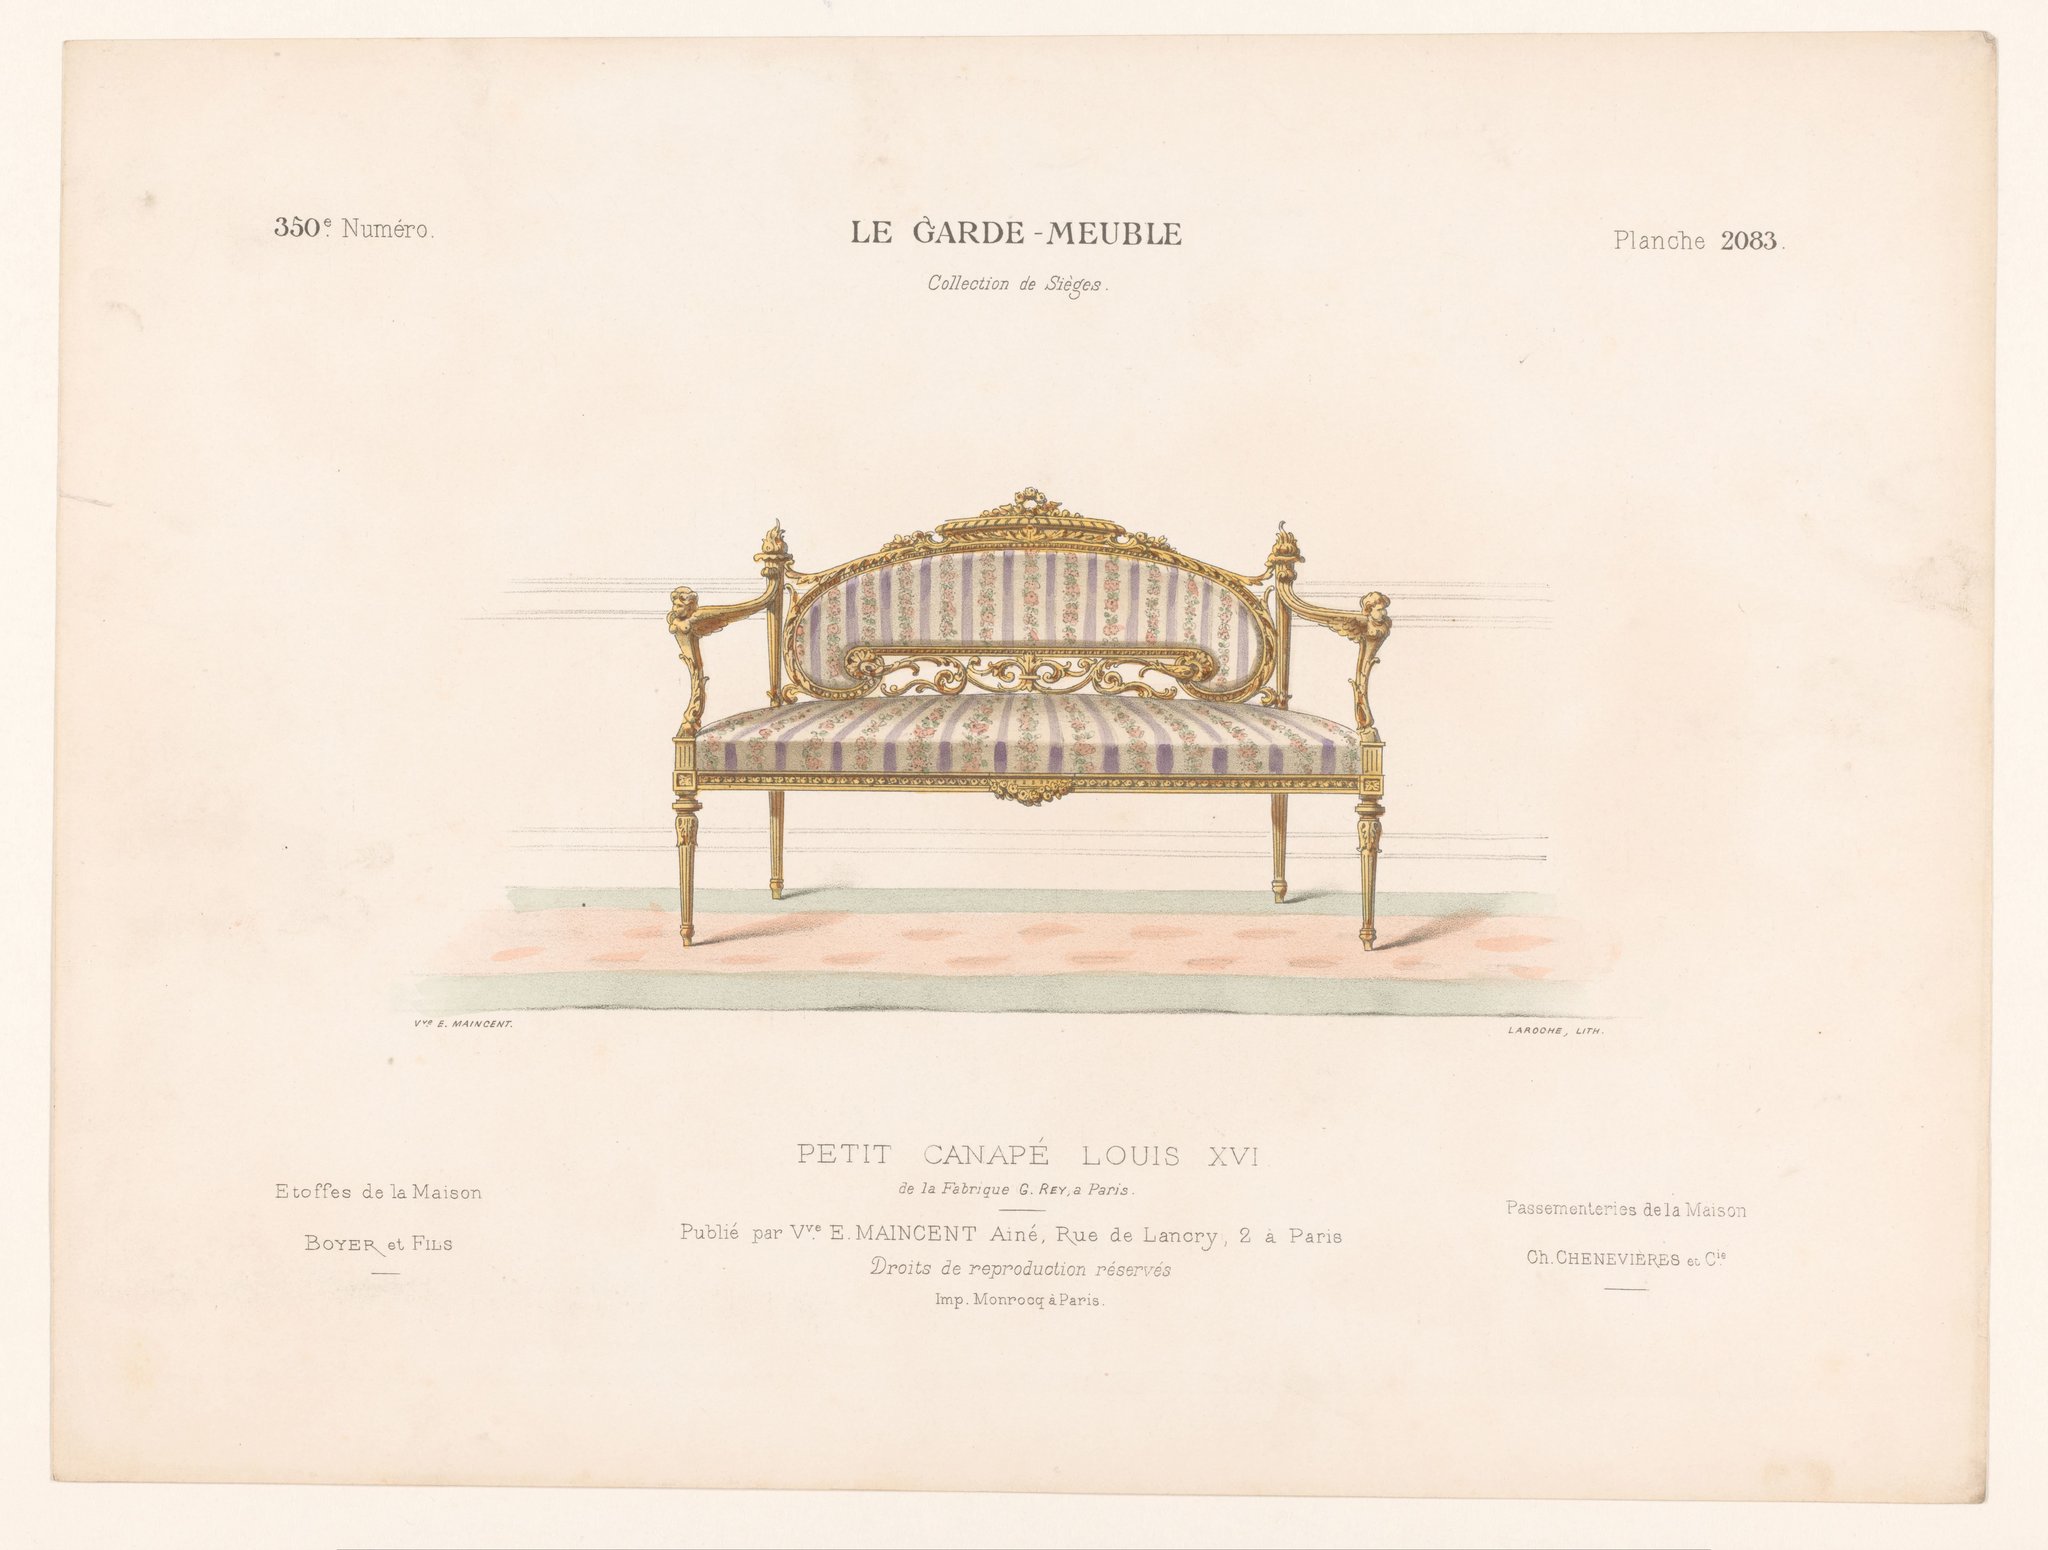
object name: print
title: Canapé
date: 1895-1935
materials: paper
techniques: hand coloring, lithograph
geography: paris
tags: seating furniture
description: Ieder Livraison in de serie Le Garde-Meuble bevat negen platen: drie 'sièges' (zitmeubels), drie 'meubles' (diverse meubels zoals tafels en kasten) en drie 'tentures' (gordijnen en draperieën).